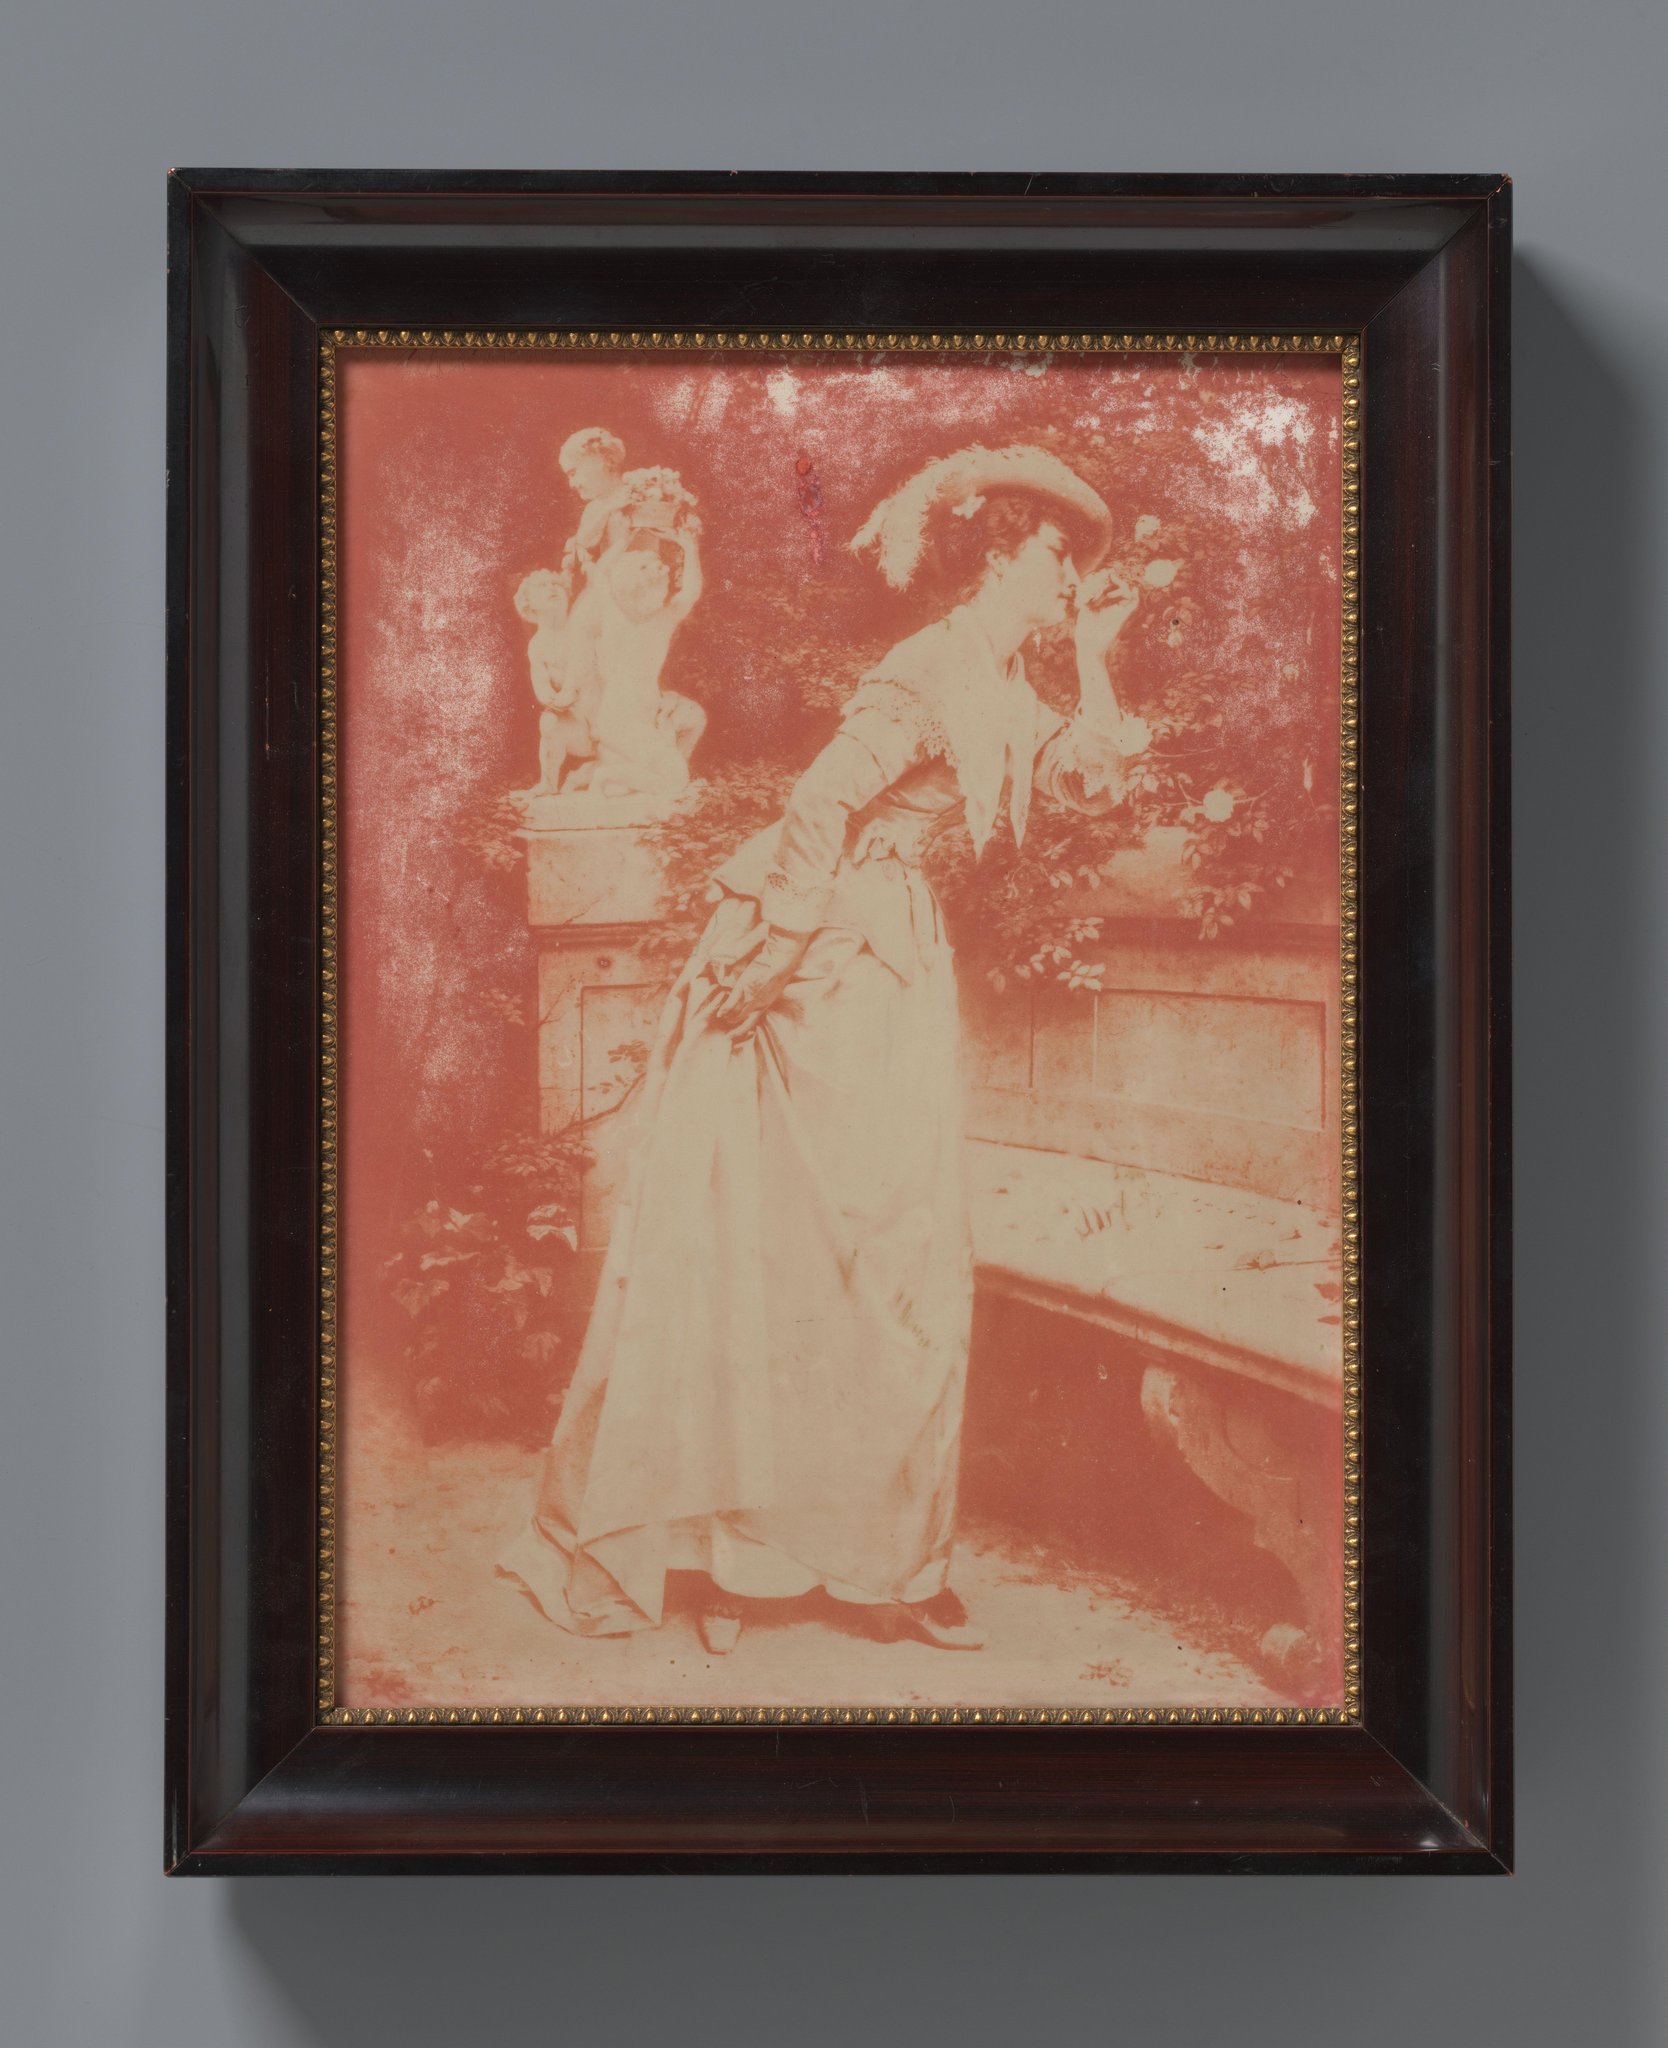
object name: photograph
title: Fotoreproductie van een schilderij van een vrouw in een tuin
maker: Anonymous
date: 1890-1910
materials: metal, porcelain, textile, wood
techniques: porcelain photography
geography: amsterdam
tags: garden, smell, smelling (one of the five senses) - aa - female human figure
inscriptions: inscription: ‘Van J. de Vries/ 1909/ Dien Luikinga 1943/ Luikinga/ 2178’, label: ‘Spiegel- en lijstenfabriek/ J. Sdt. Fetter/ Vijzelstraat/ 126/ Telef. 3617/ Amsterdam’